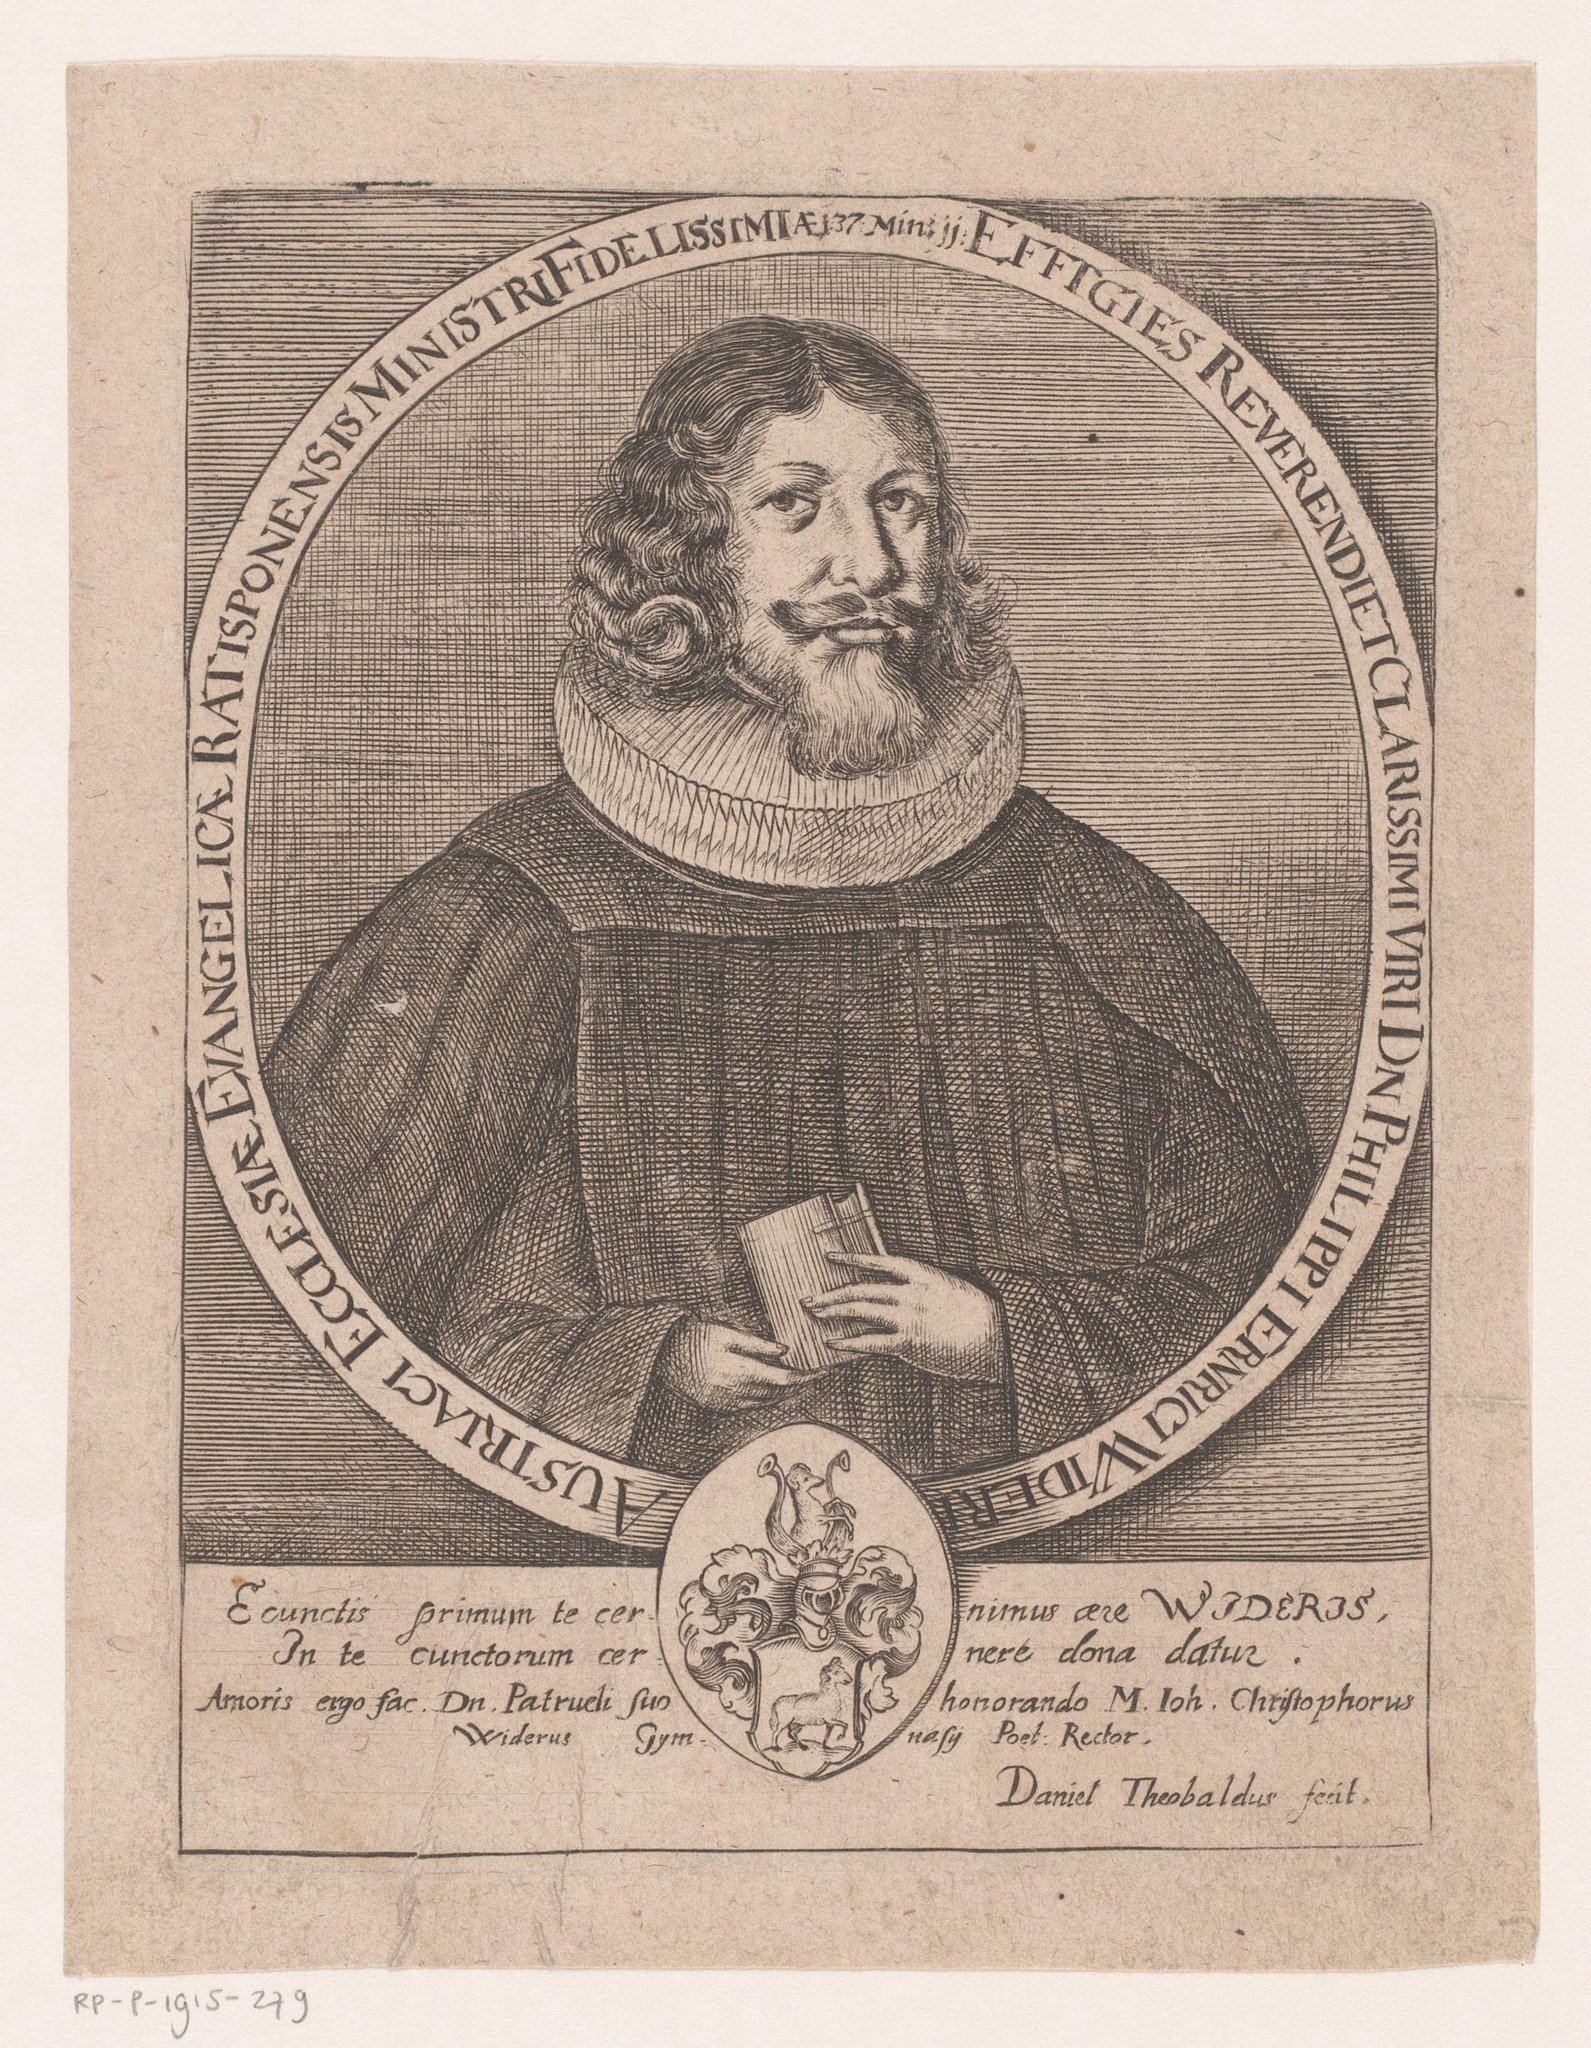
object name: print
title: Portret van Philipp Ehrenreich Wider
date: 1655-1700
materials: paper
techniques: engraving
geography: frankfurt am main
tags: philipp ehrenreich wider, historical persons, armorial bearing, heraldry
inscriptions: collector's mark: Lugt 2228